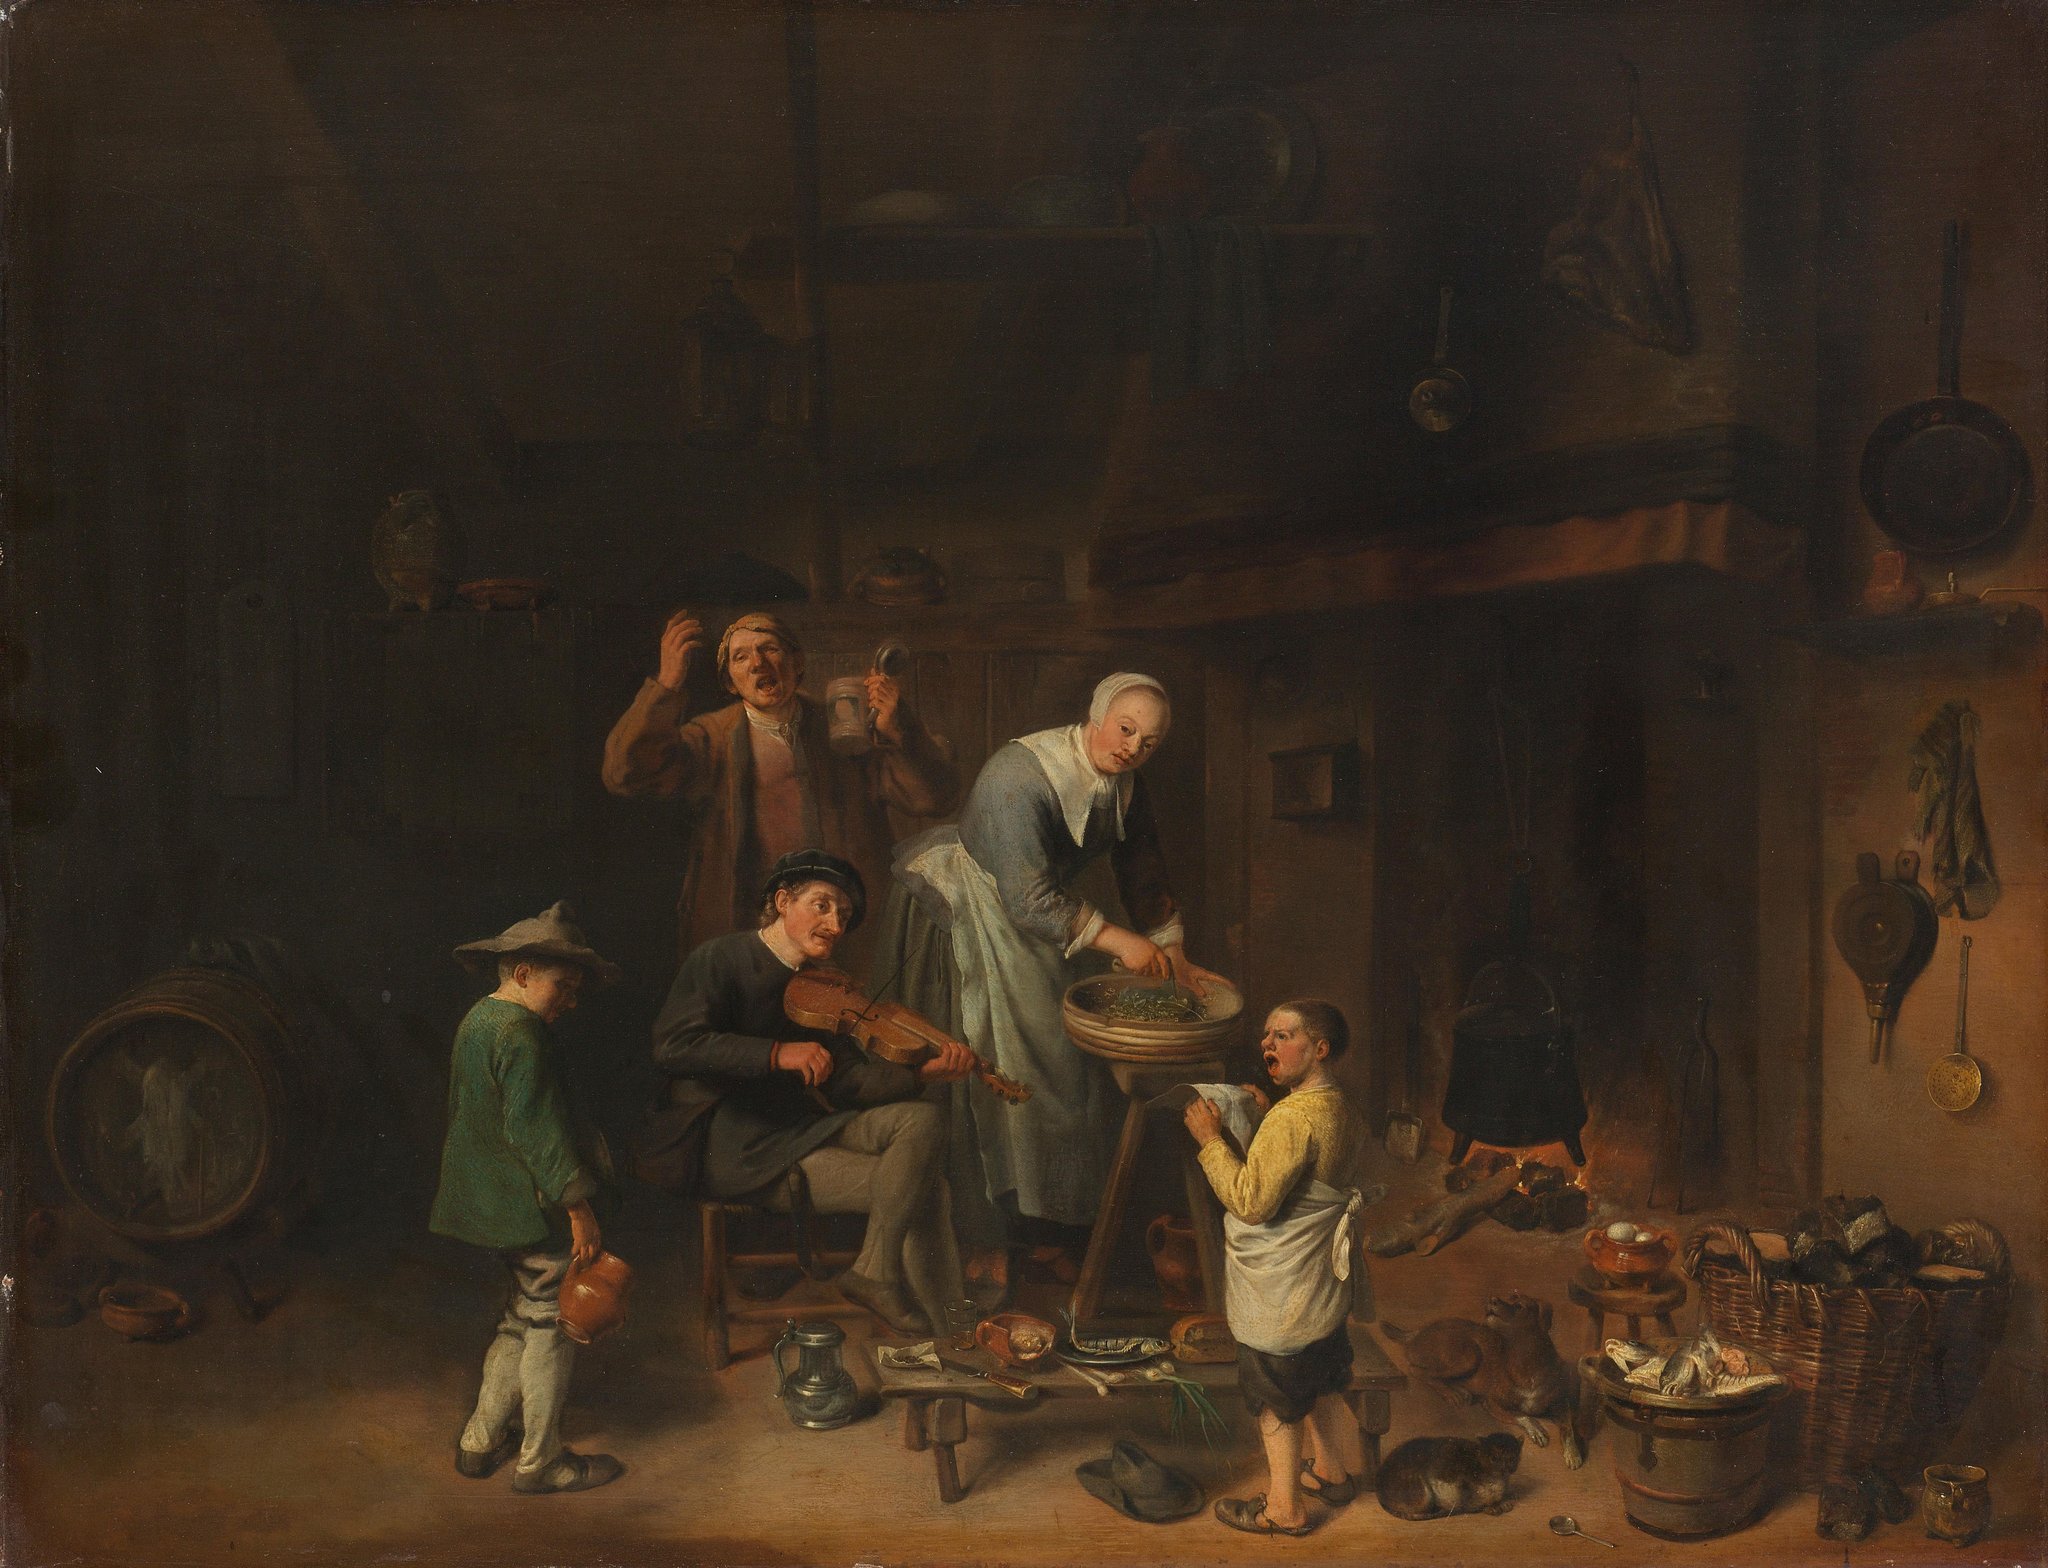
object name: painting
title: Peasant Family Singing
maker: pieter jacobsz. duyfhuysen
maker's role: painter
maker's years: 1608-1677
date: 1640-1677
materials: oil, panel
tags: instrumental and vocal music together, family group, especially parents with their child(ren), kitchen-interior, farm (building) - aa - civic architecture: inside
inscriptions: signature, on a cupboard in the centre (false): ‘PVSlingerland Fecit ’, signature and date, bottom left (P, J and D ligated): ‘PJD […] […]4’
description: Zingende boerenfamilie. Interieur van een boerenwoning met vijf personen. In het midden een man met een viool, daarachter een zingende man met een kan bier, rechts een werkende vrouw, rechtsvoor een zingende jongen met een blad papier en links een jongen met een kruik. Rechts en boven de haard allerlei huisraad, een hond en een kat en een bord met vis. Links een wijnvat.